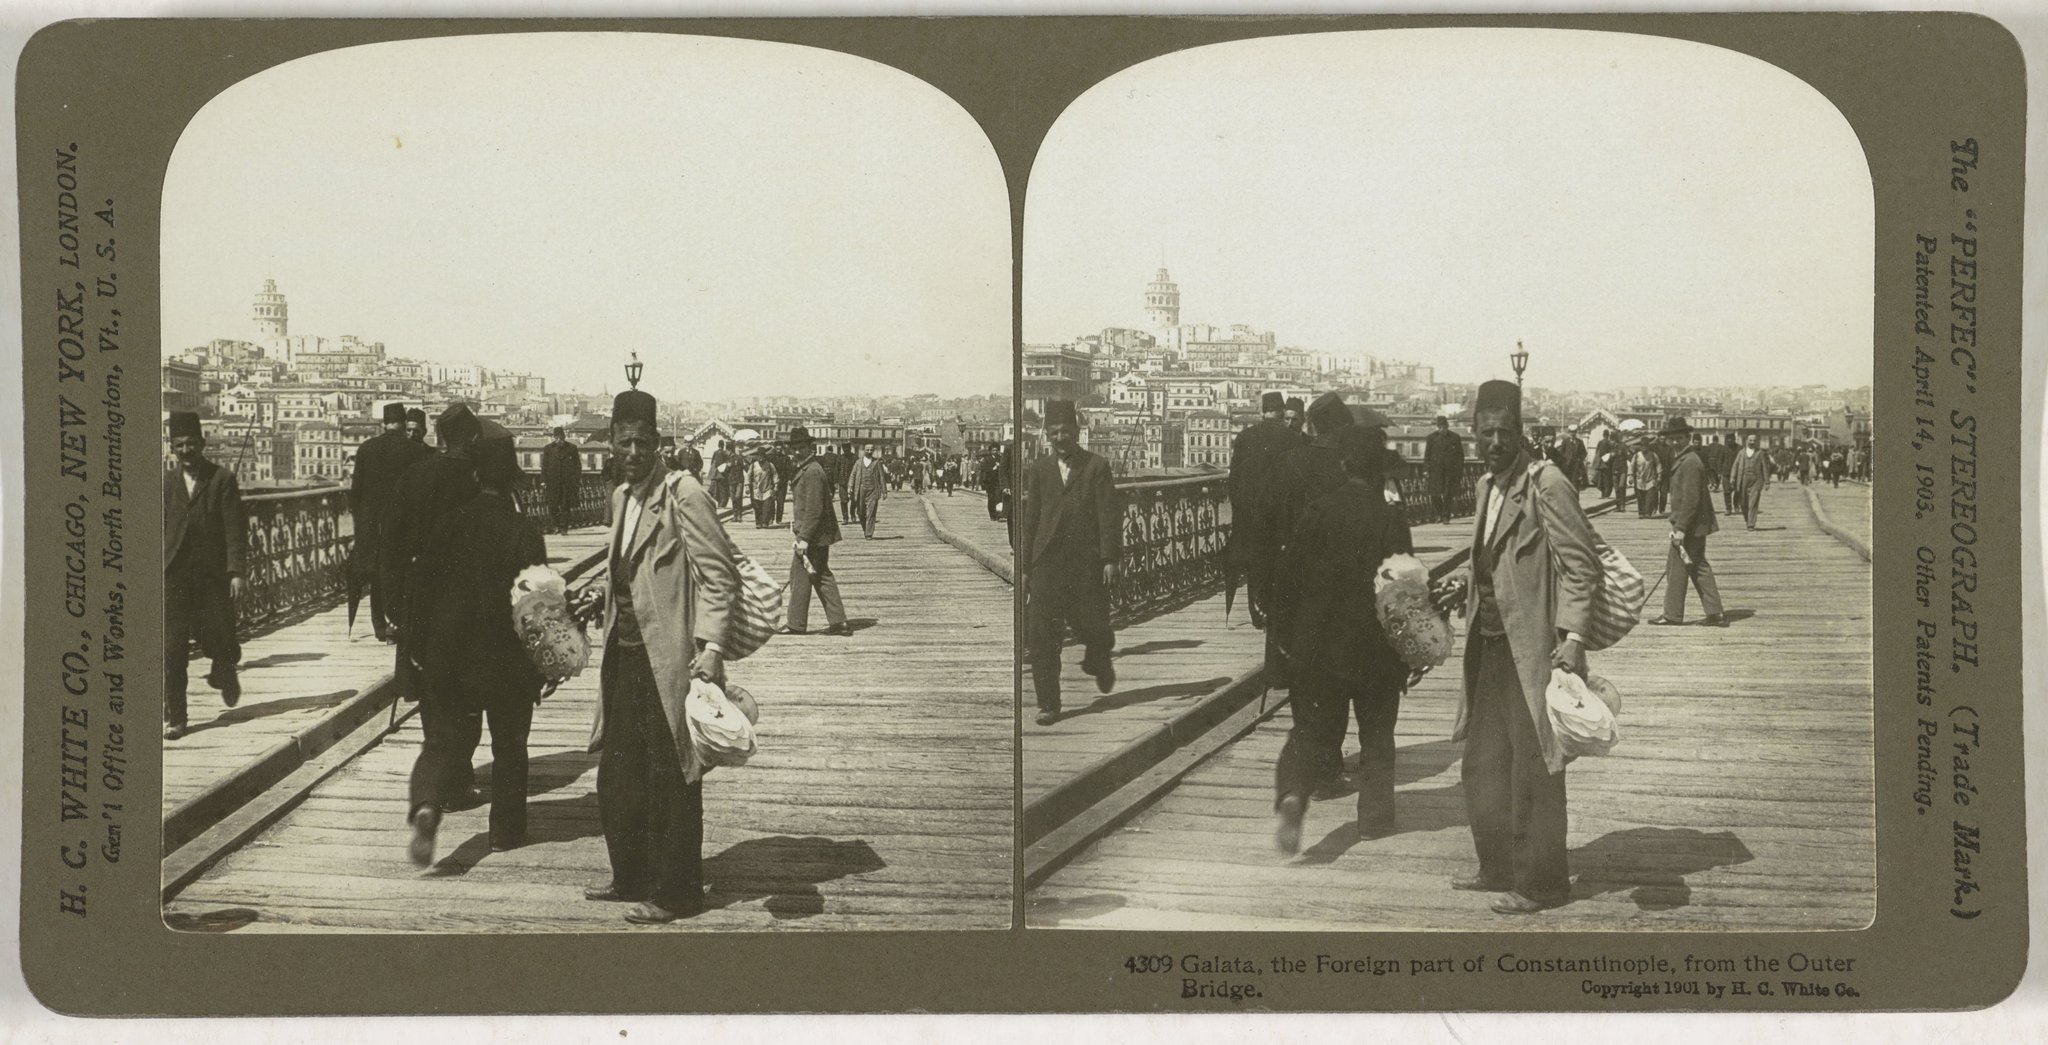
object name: stereograph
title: Galata, the Foreign part of Constantinople, from the Outer Bridge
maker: Anonymous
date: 1901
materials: paper, cardboard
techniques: gelatin silver print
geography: new york city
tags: pontoon bridge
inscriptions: inscription: ‘The " PERFEC" STEREOGRAPH. (Trade Mark.)/ Patented April 14, 1903. Other Patents Pending.’, number: ‘4309.’, copyright notice: ‘Copyright 1901 by H. C. White Co.’, number: ‘3’